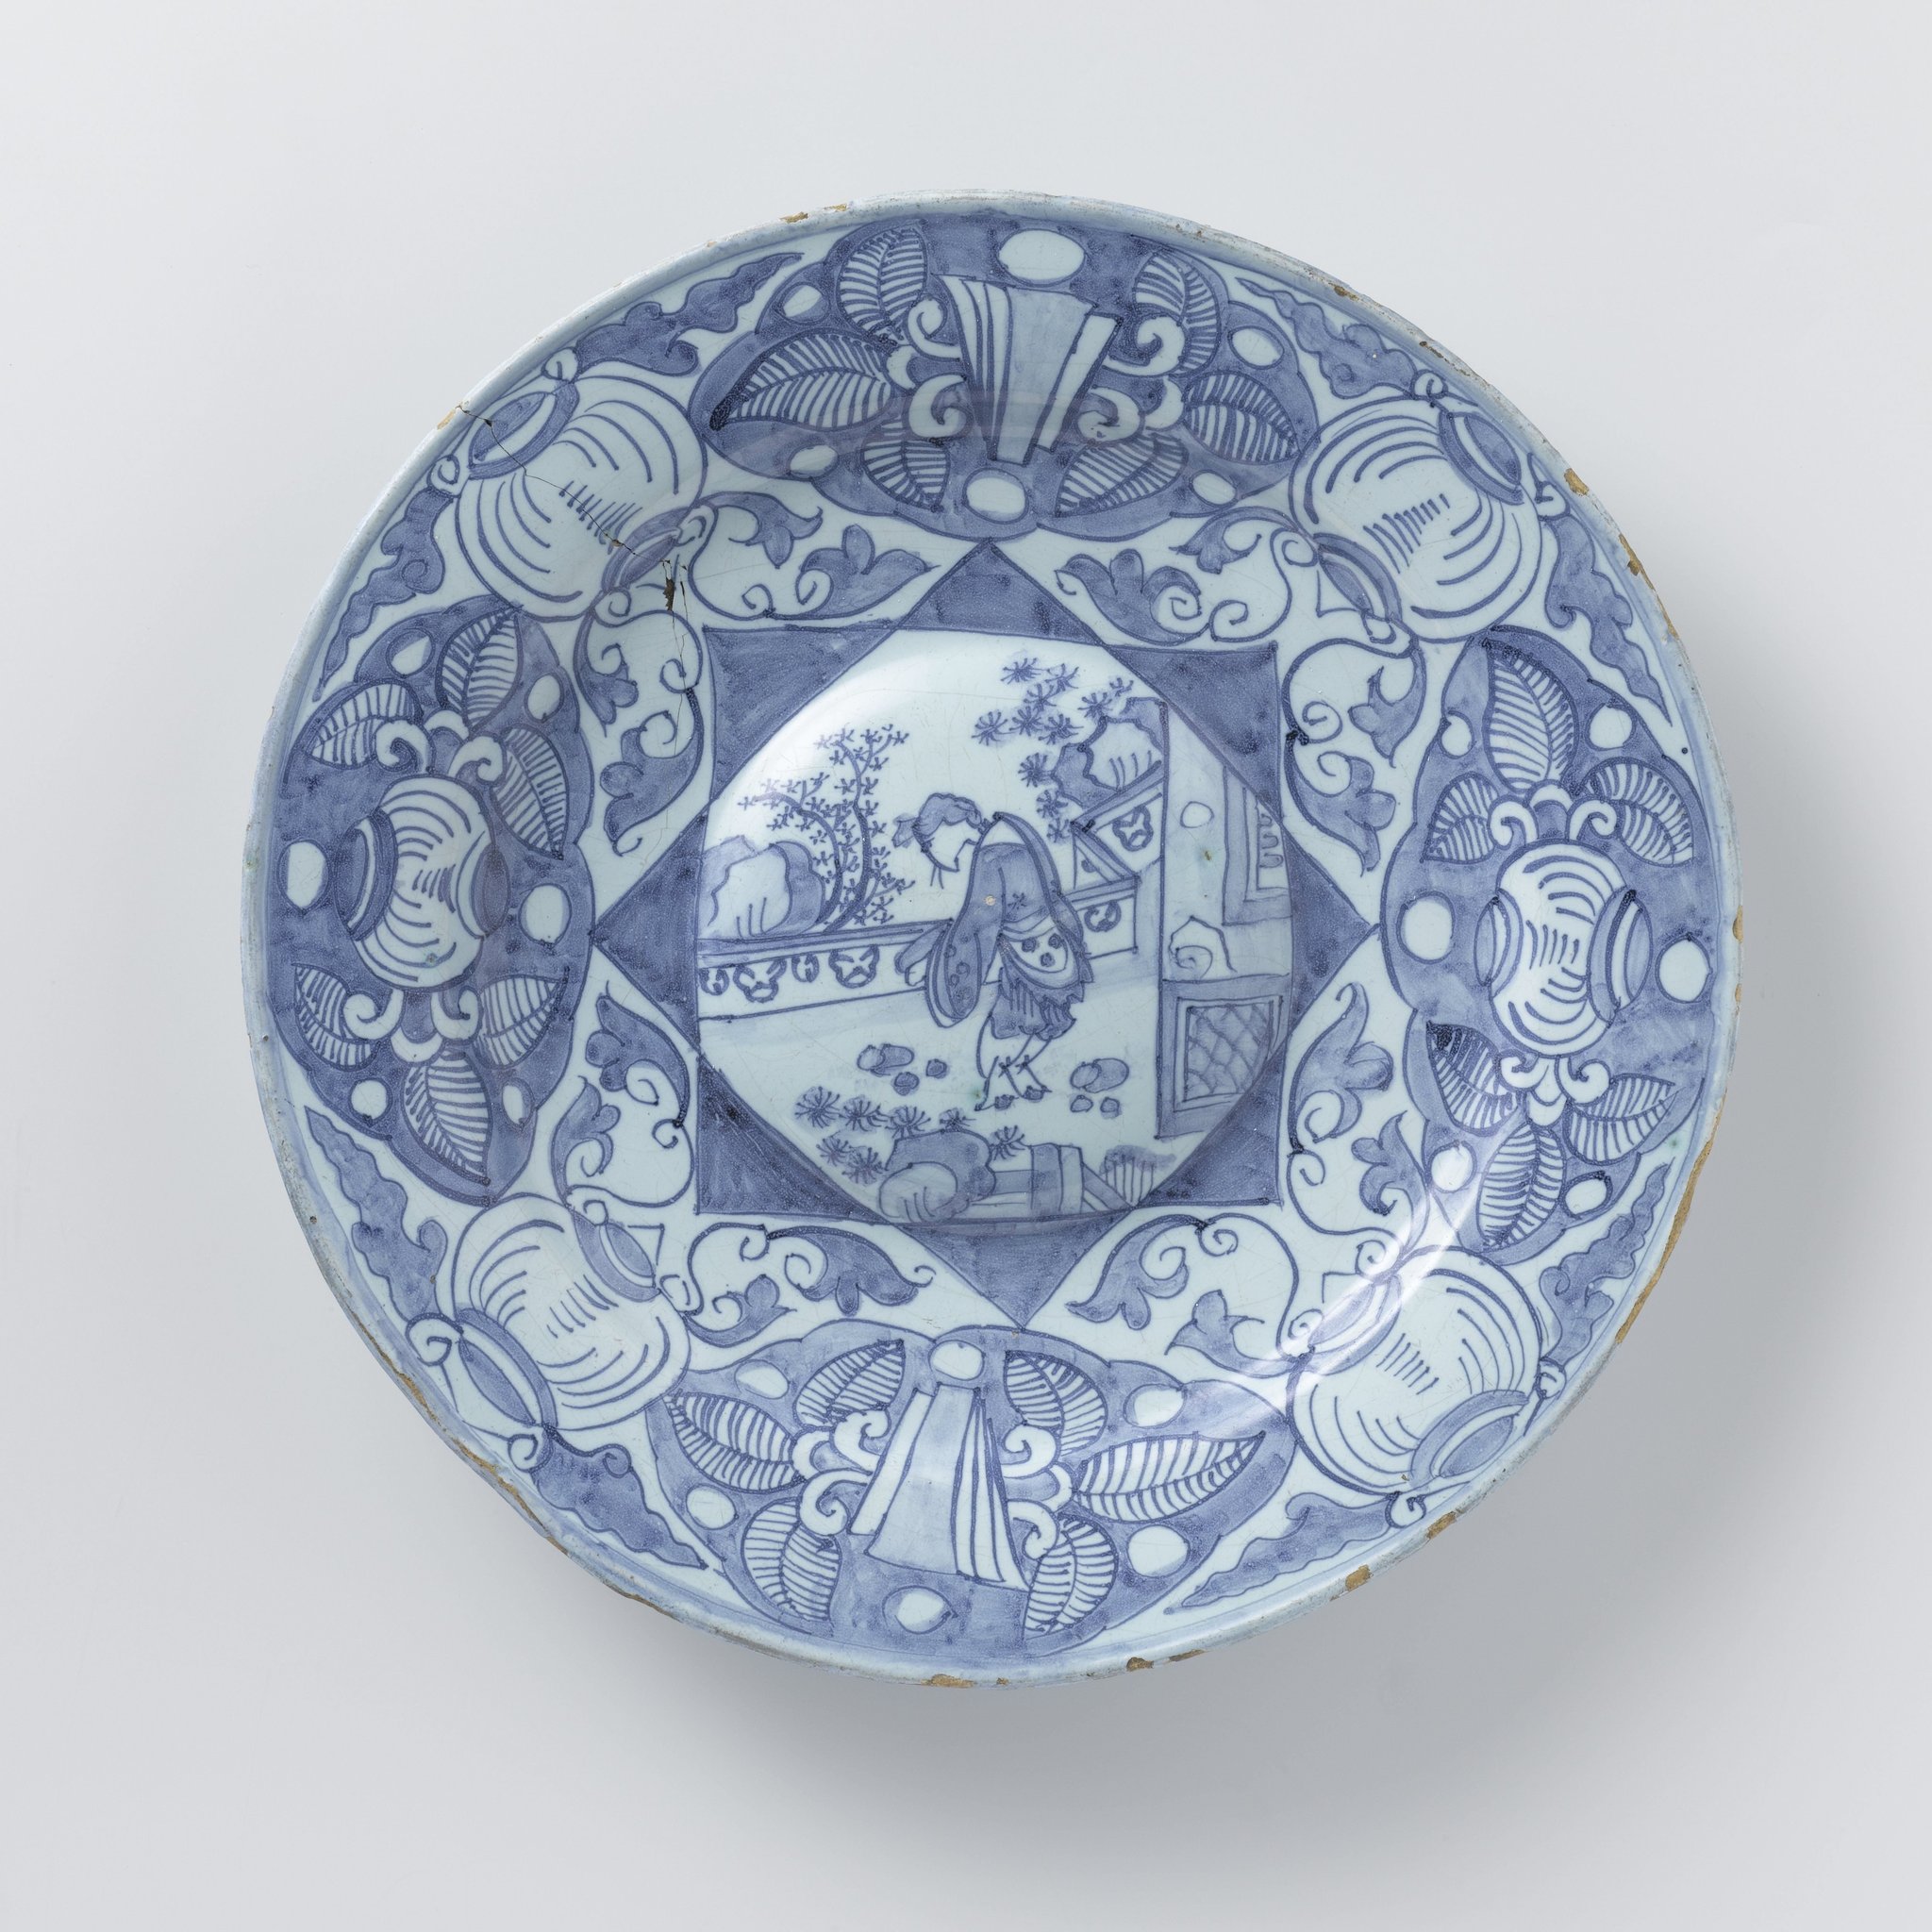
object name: platter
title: Schotel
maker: Anonymous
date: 1660-1680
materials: earthenware, glaze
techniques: painted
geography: delft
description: Schotel van blauw beschilderde faience, met een gebombeerde bodem. Op de bodem is een achtpuntige ster, waarbinnen een cirkel geschilderd en in de cirkel een afbeelding van een vrouwenfiguur op een terras. De rand is met ornamenten beschilderd.